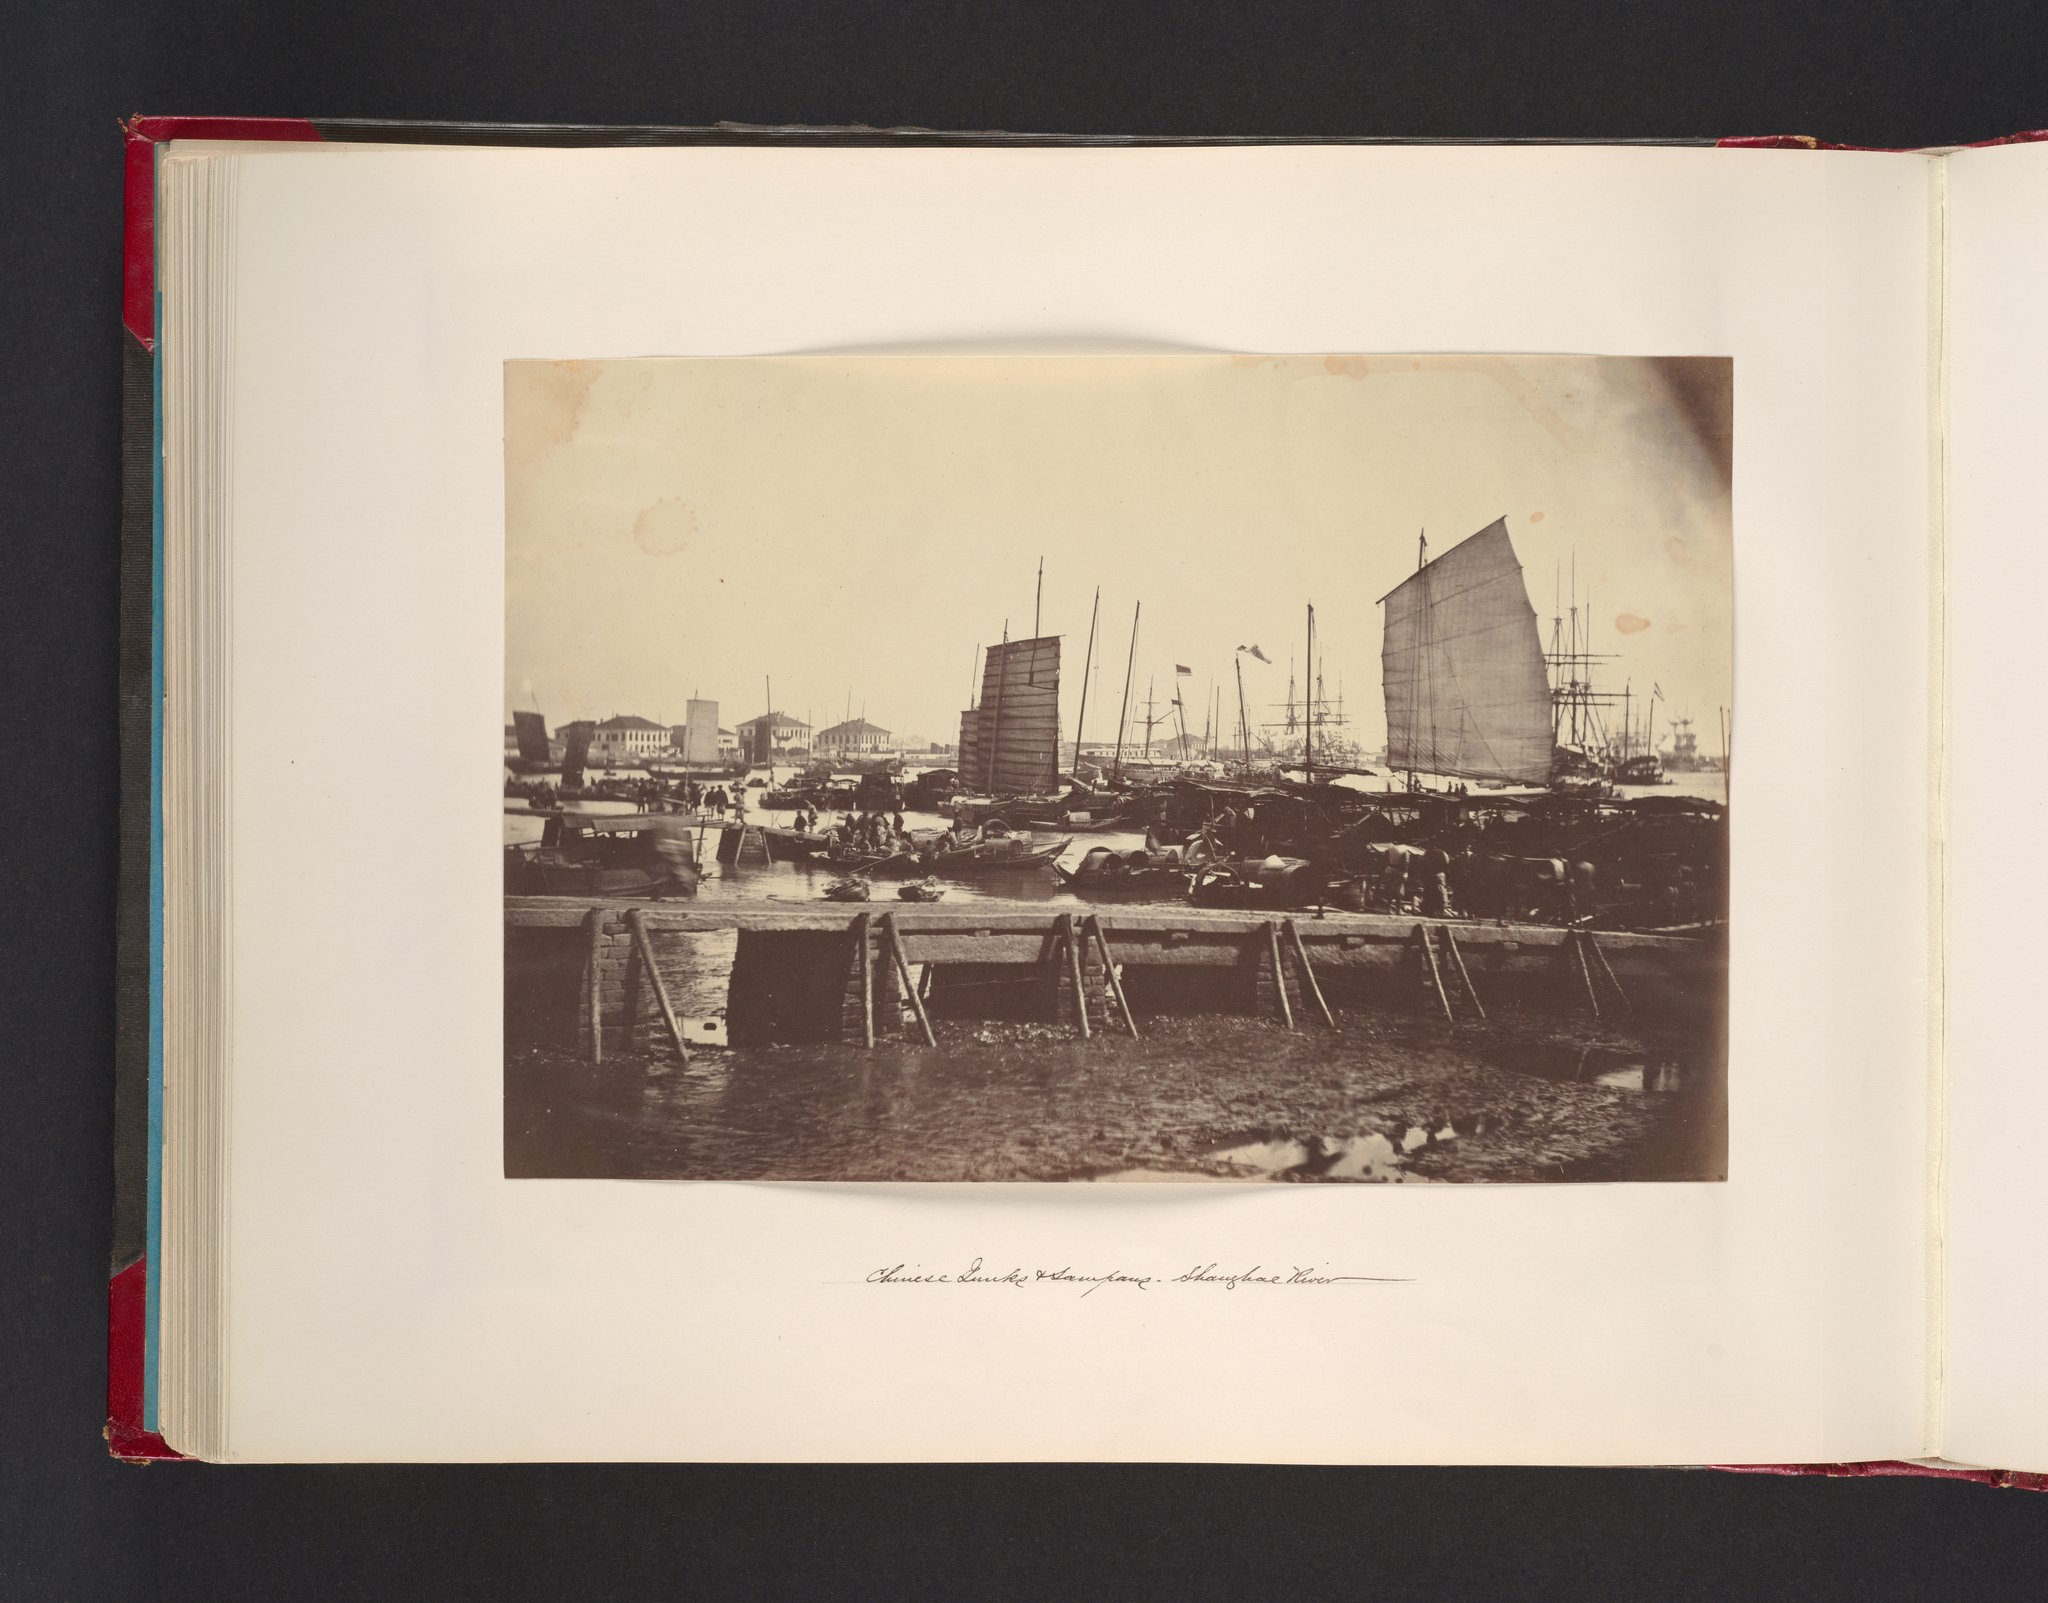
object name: photograph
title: Chinese Junks Sampans, Shanghai River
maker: john thomson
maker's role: artist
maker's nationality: british, scottish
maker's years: 1837-1921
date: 1865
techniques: albumen silver print, glass negative